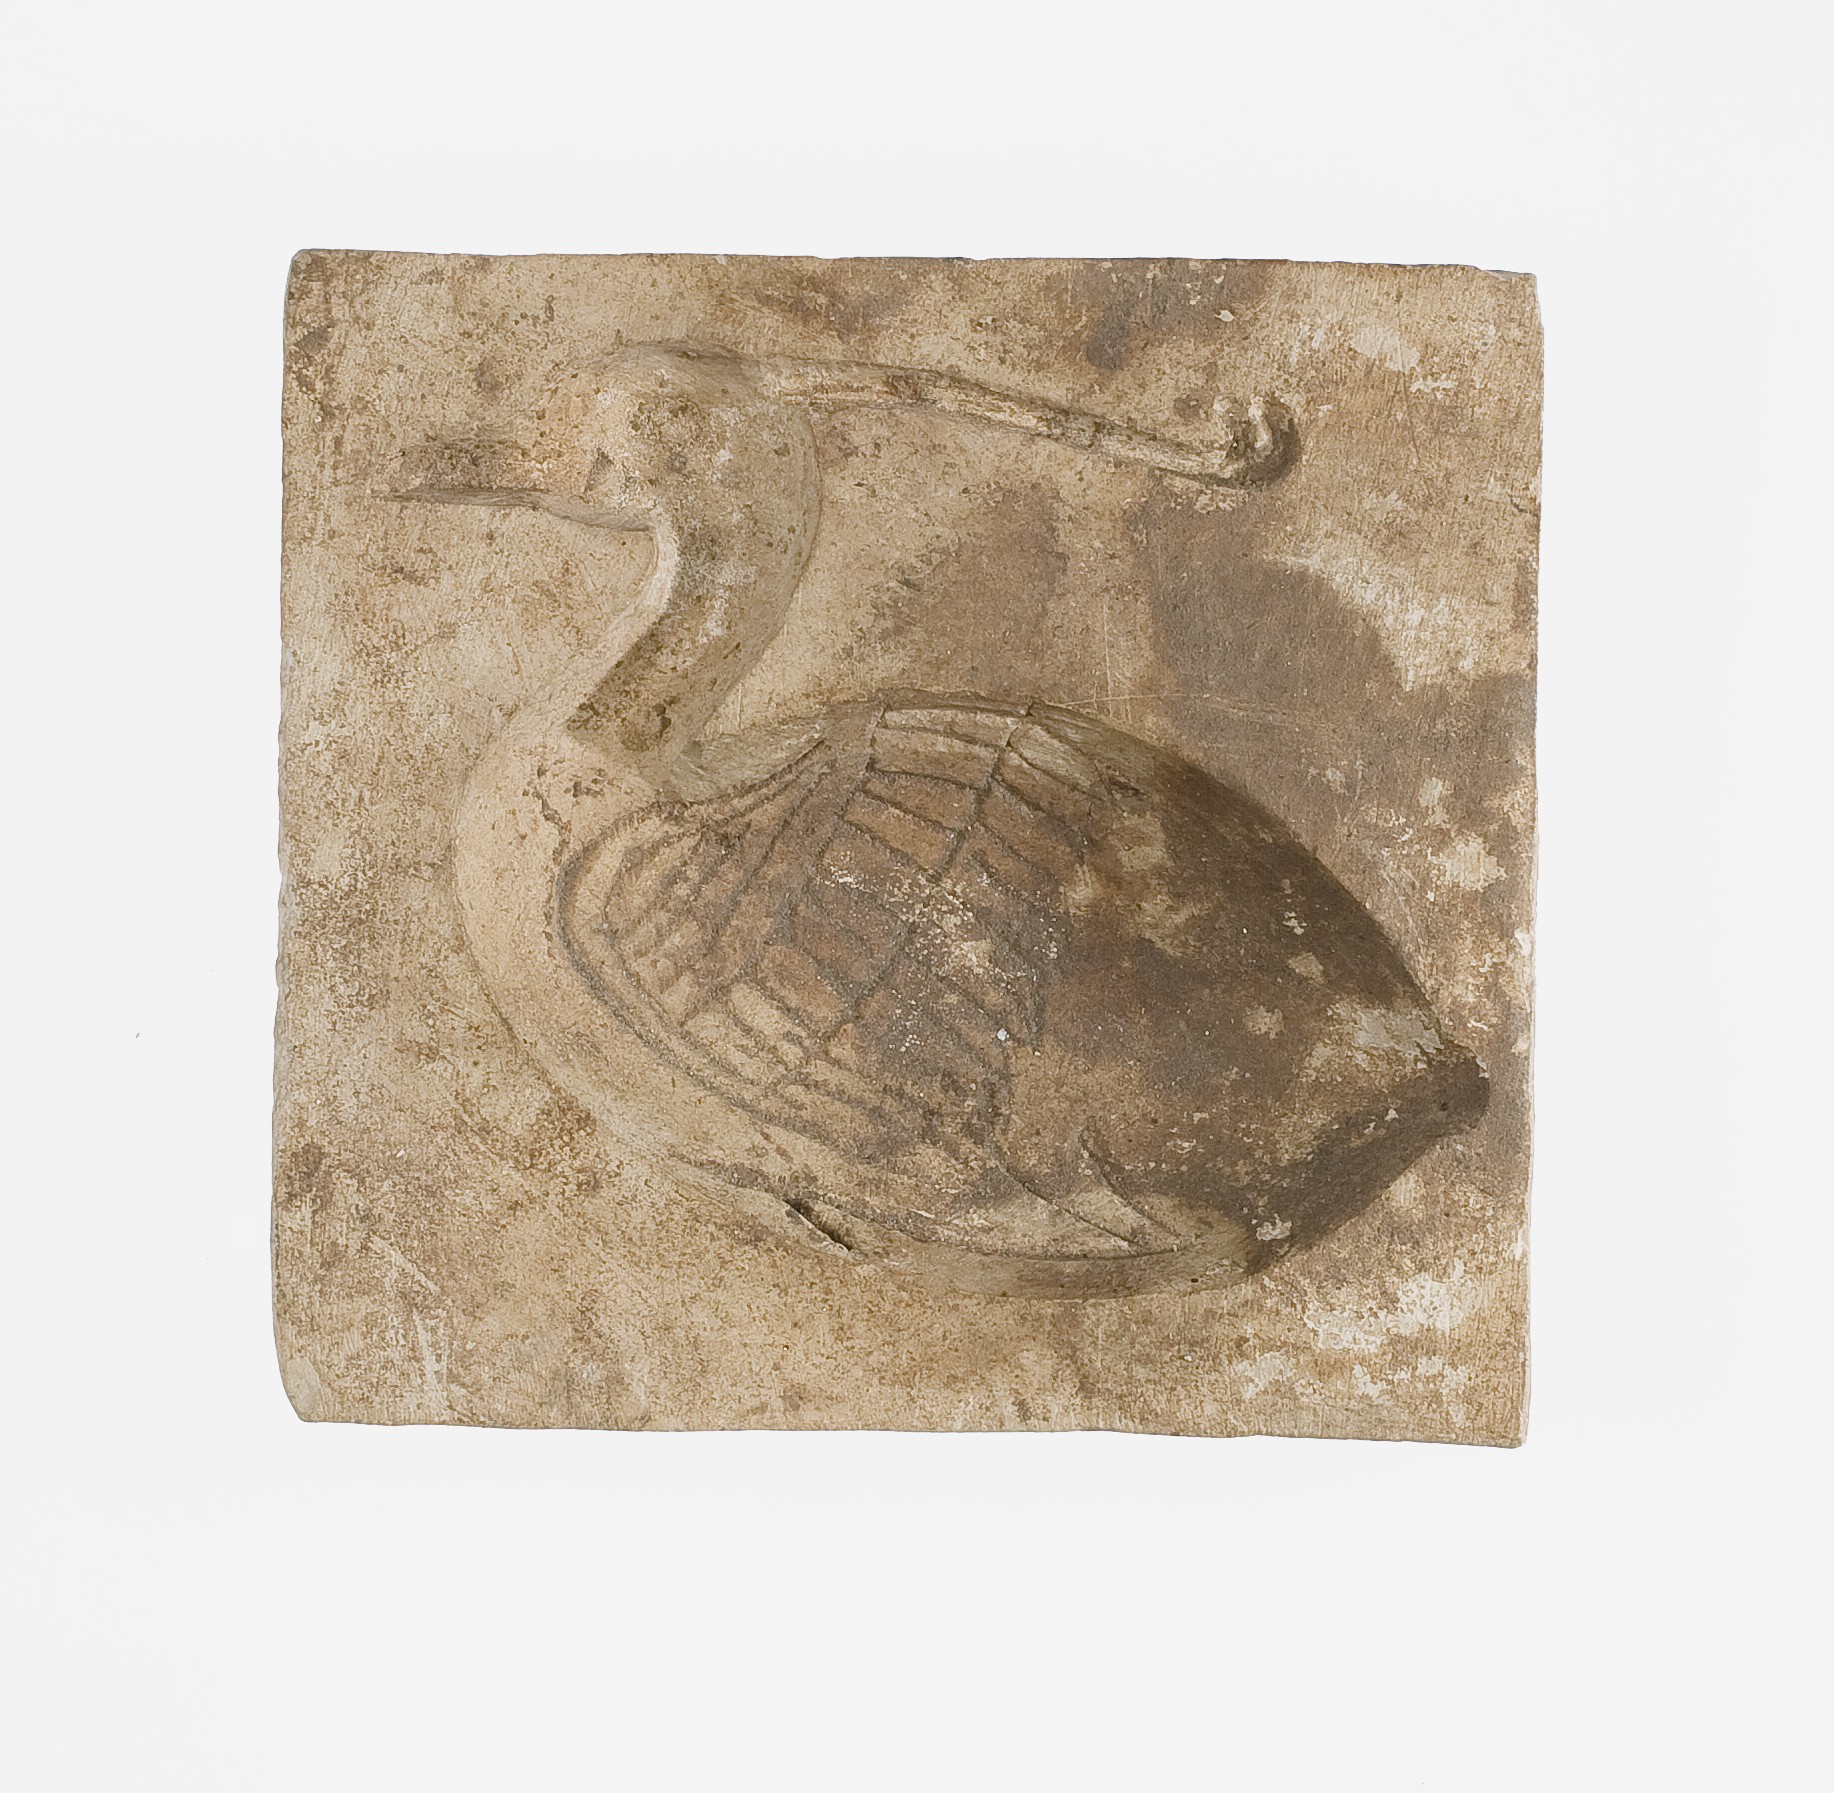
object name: mold, bird, bennu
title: Mold for Figure of Bird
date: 1390-1352 BCE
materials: limestone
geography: egypt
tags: birds